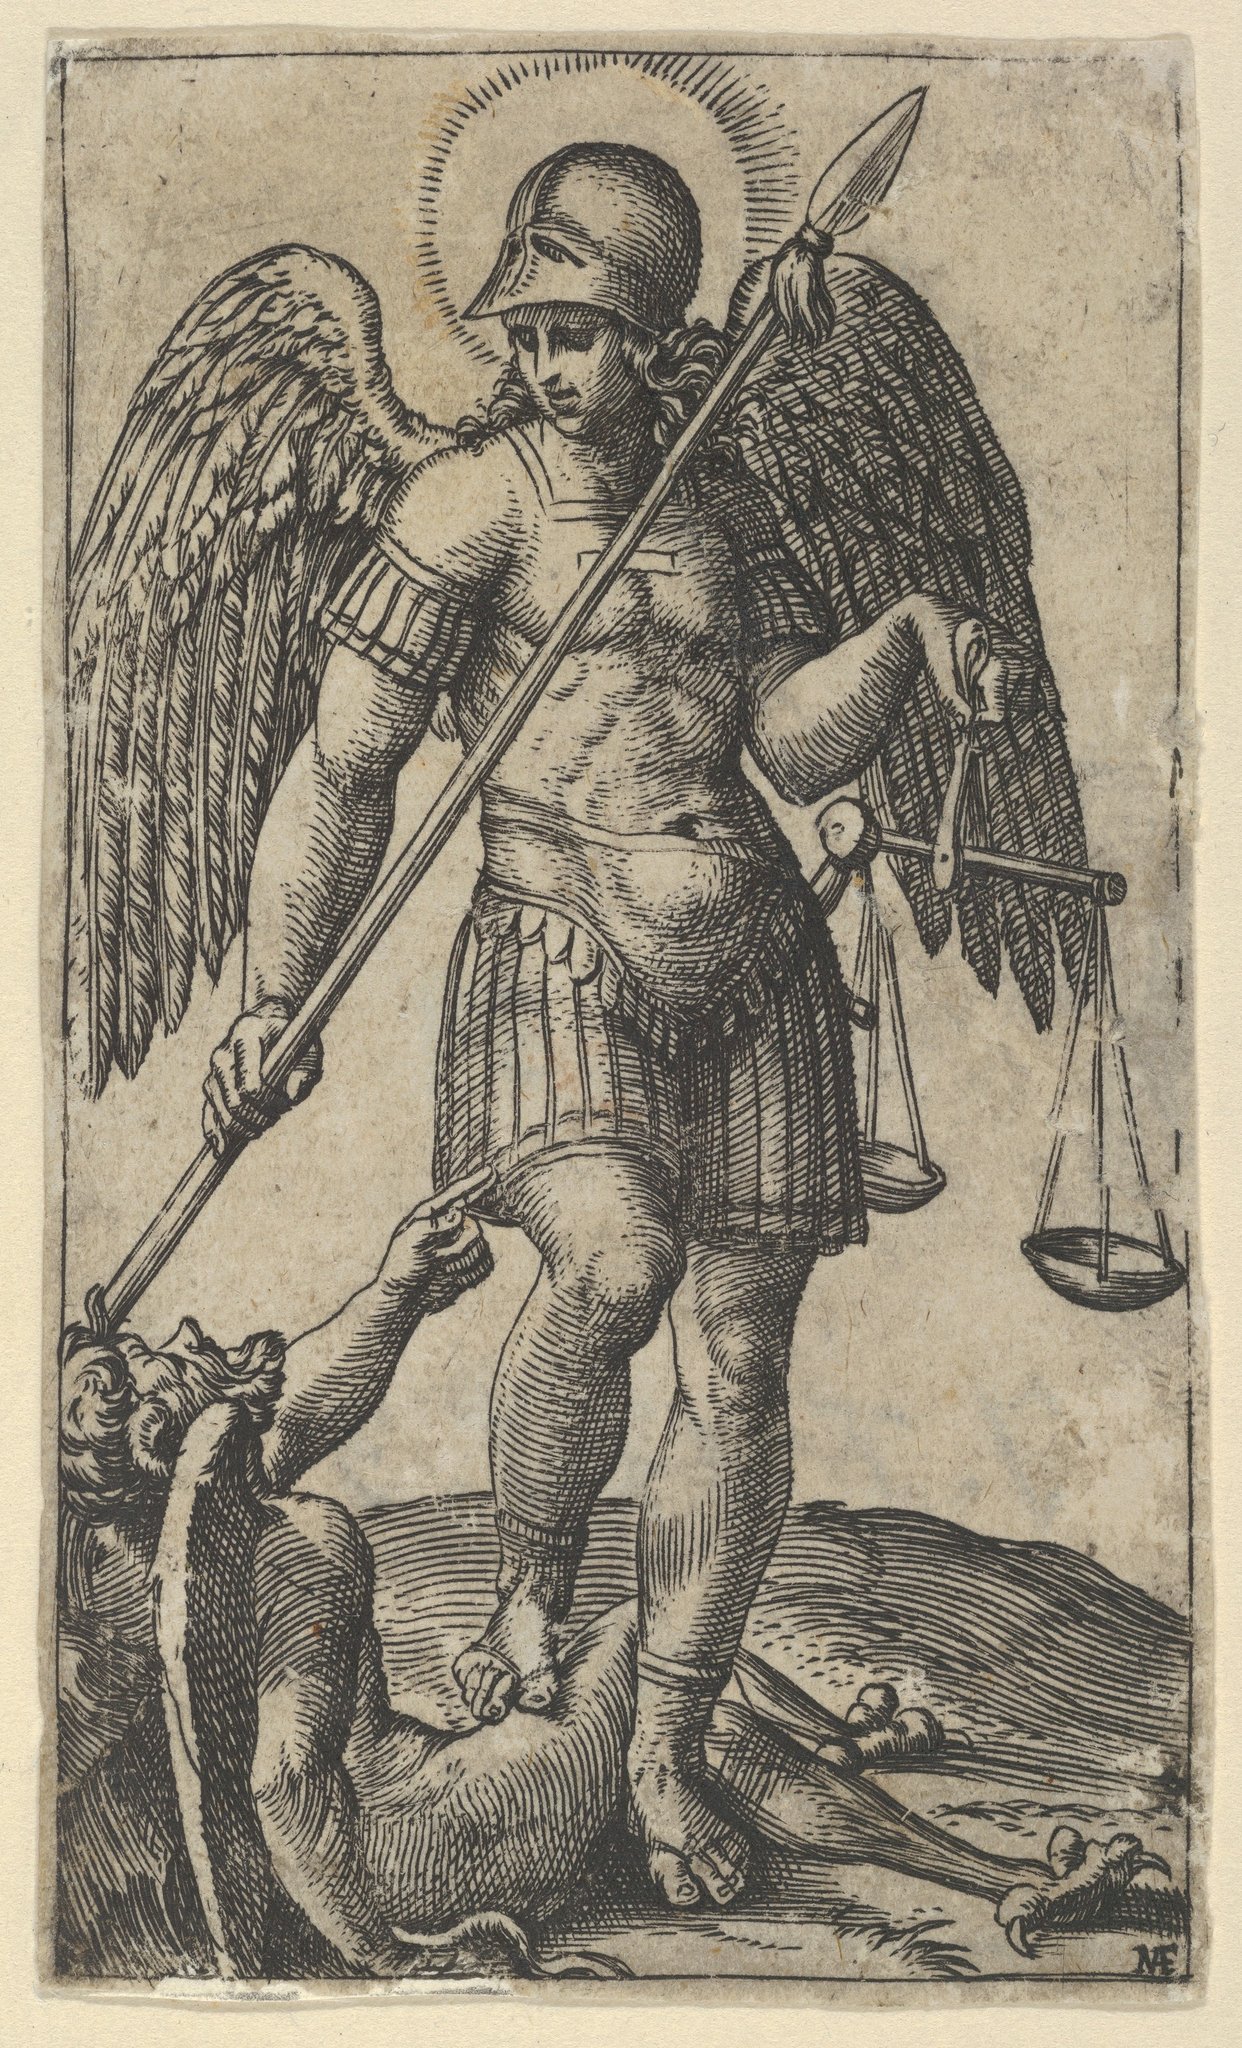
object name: print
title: Saint Michael holding scales and a lance, a demon beneath him, from "Piccoli Santi" (Small Saints)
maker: marcantonio raimondi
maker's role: artist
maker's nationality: italian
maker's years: 1475-1534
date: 1500-1527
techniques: engraving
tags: saint michael,demons,scales